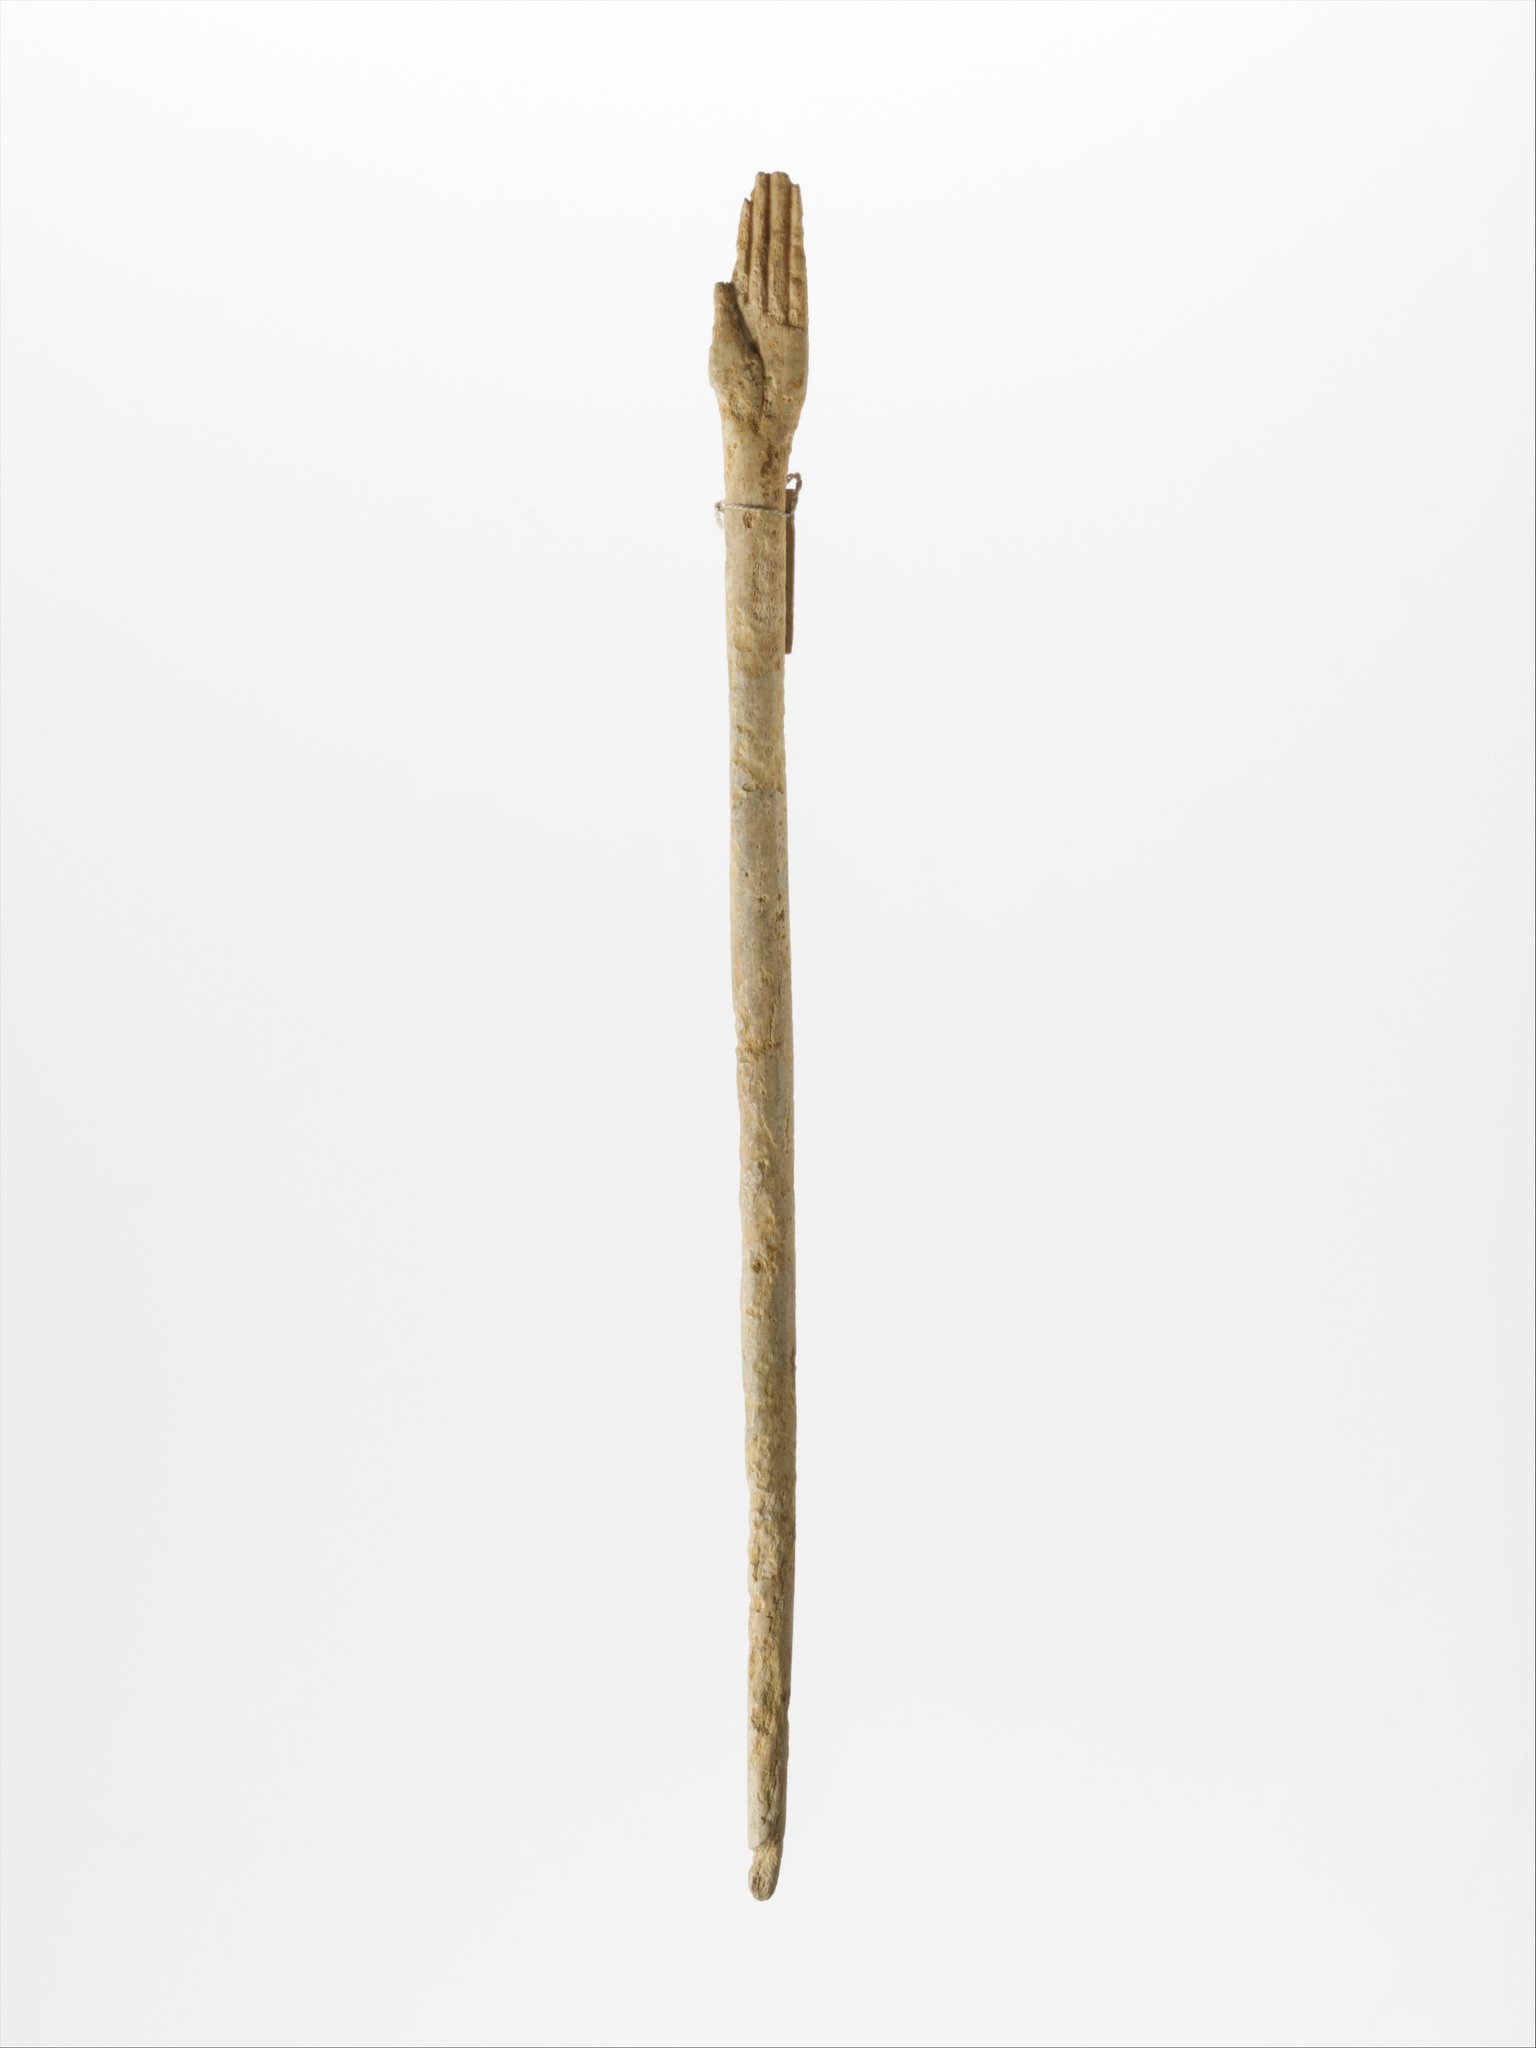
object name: stylus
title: Bone pin with head in the form of a hand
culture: roman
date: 34-300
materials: bone, ivory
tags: hands